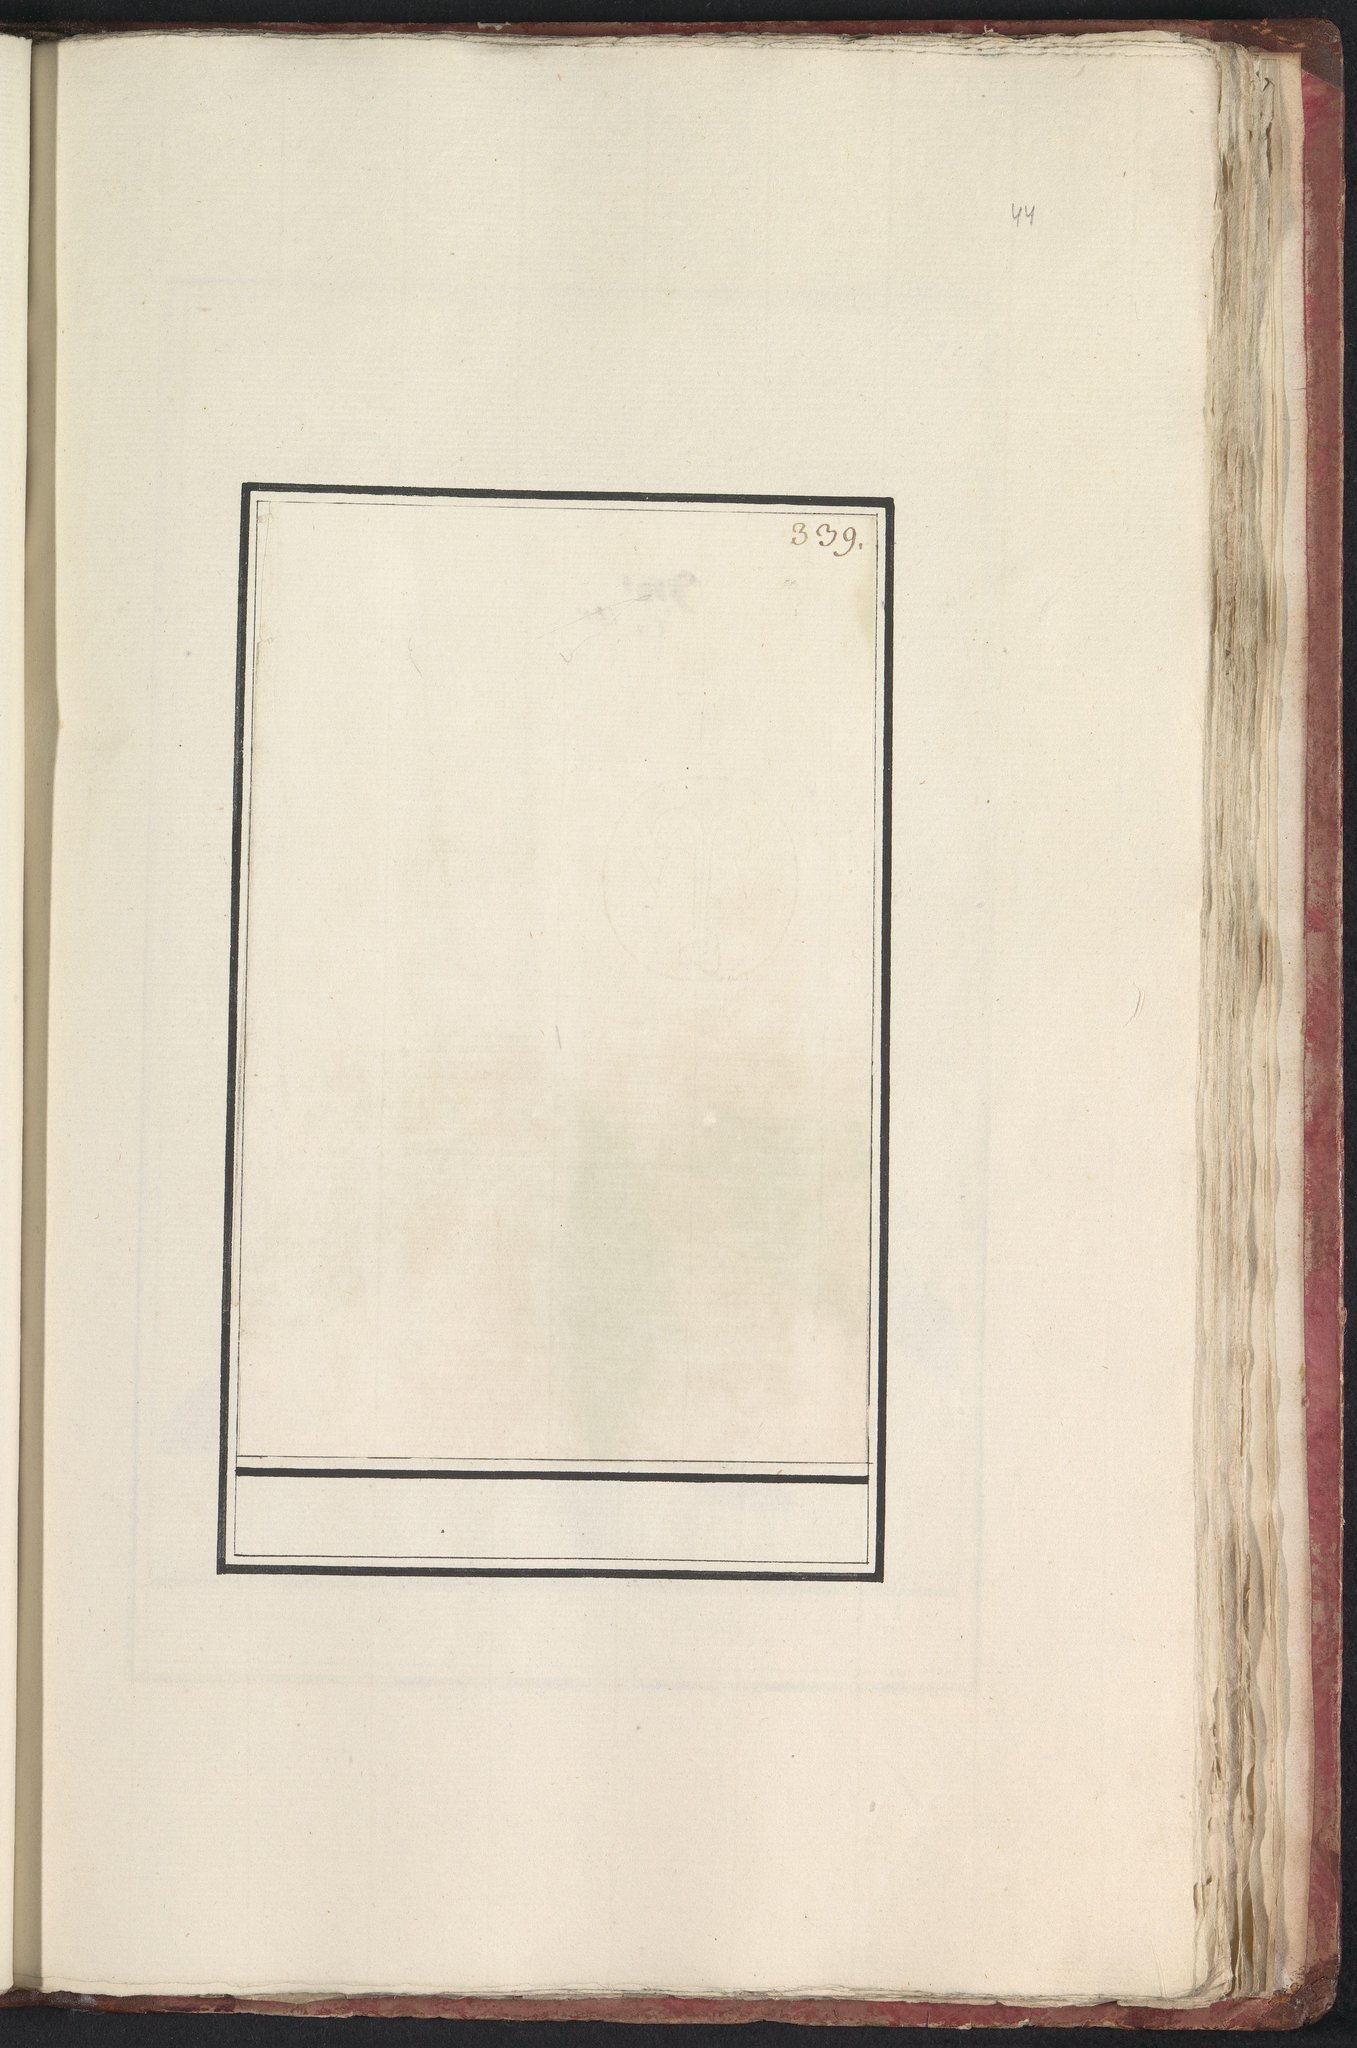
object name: drawing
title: Omlijsting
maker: Anonymous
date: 1809-1814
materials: paper, pencil, watercolor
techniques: brush, pen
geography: southern netherlands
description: Lege omlijsting. Rechtsboven genummerd: 339. Onderdeel van het vierde album met tekeningen van bloemen en paddestoelen. Elfde van twaalf albums met tekeningen van dieren, vogels en planten bekend rond 1600, gemaakt in opdracht van keizer Rudolf II. Met toelichting in Nederlands, Latijn en Frans.